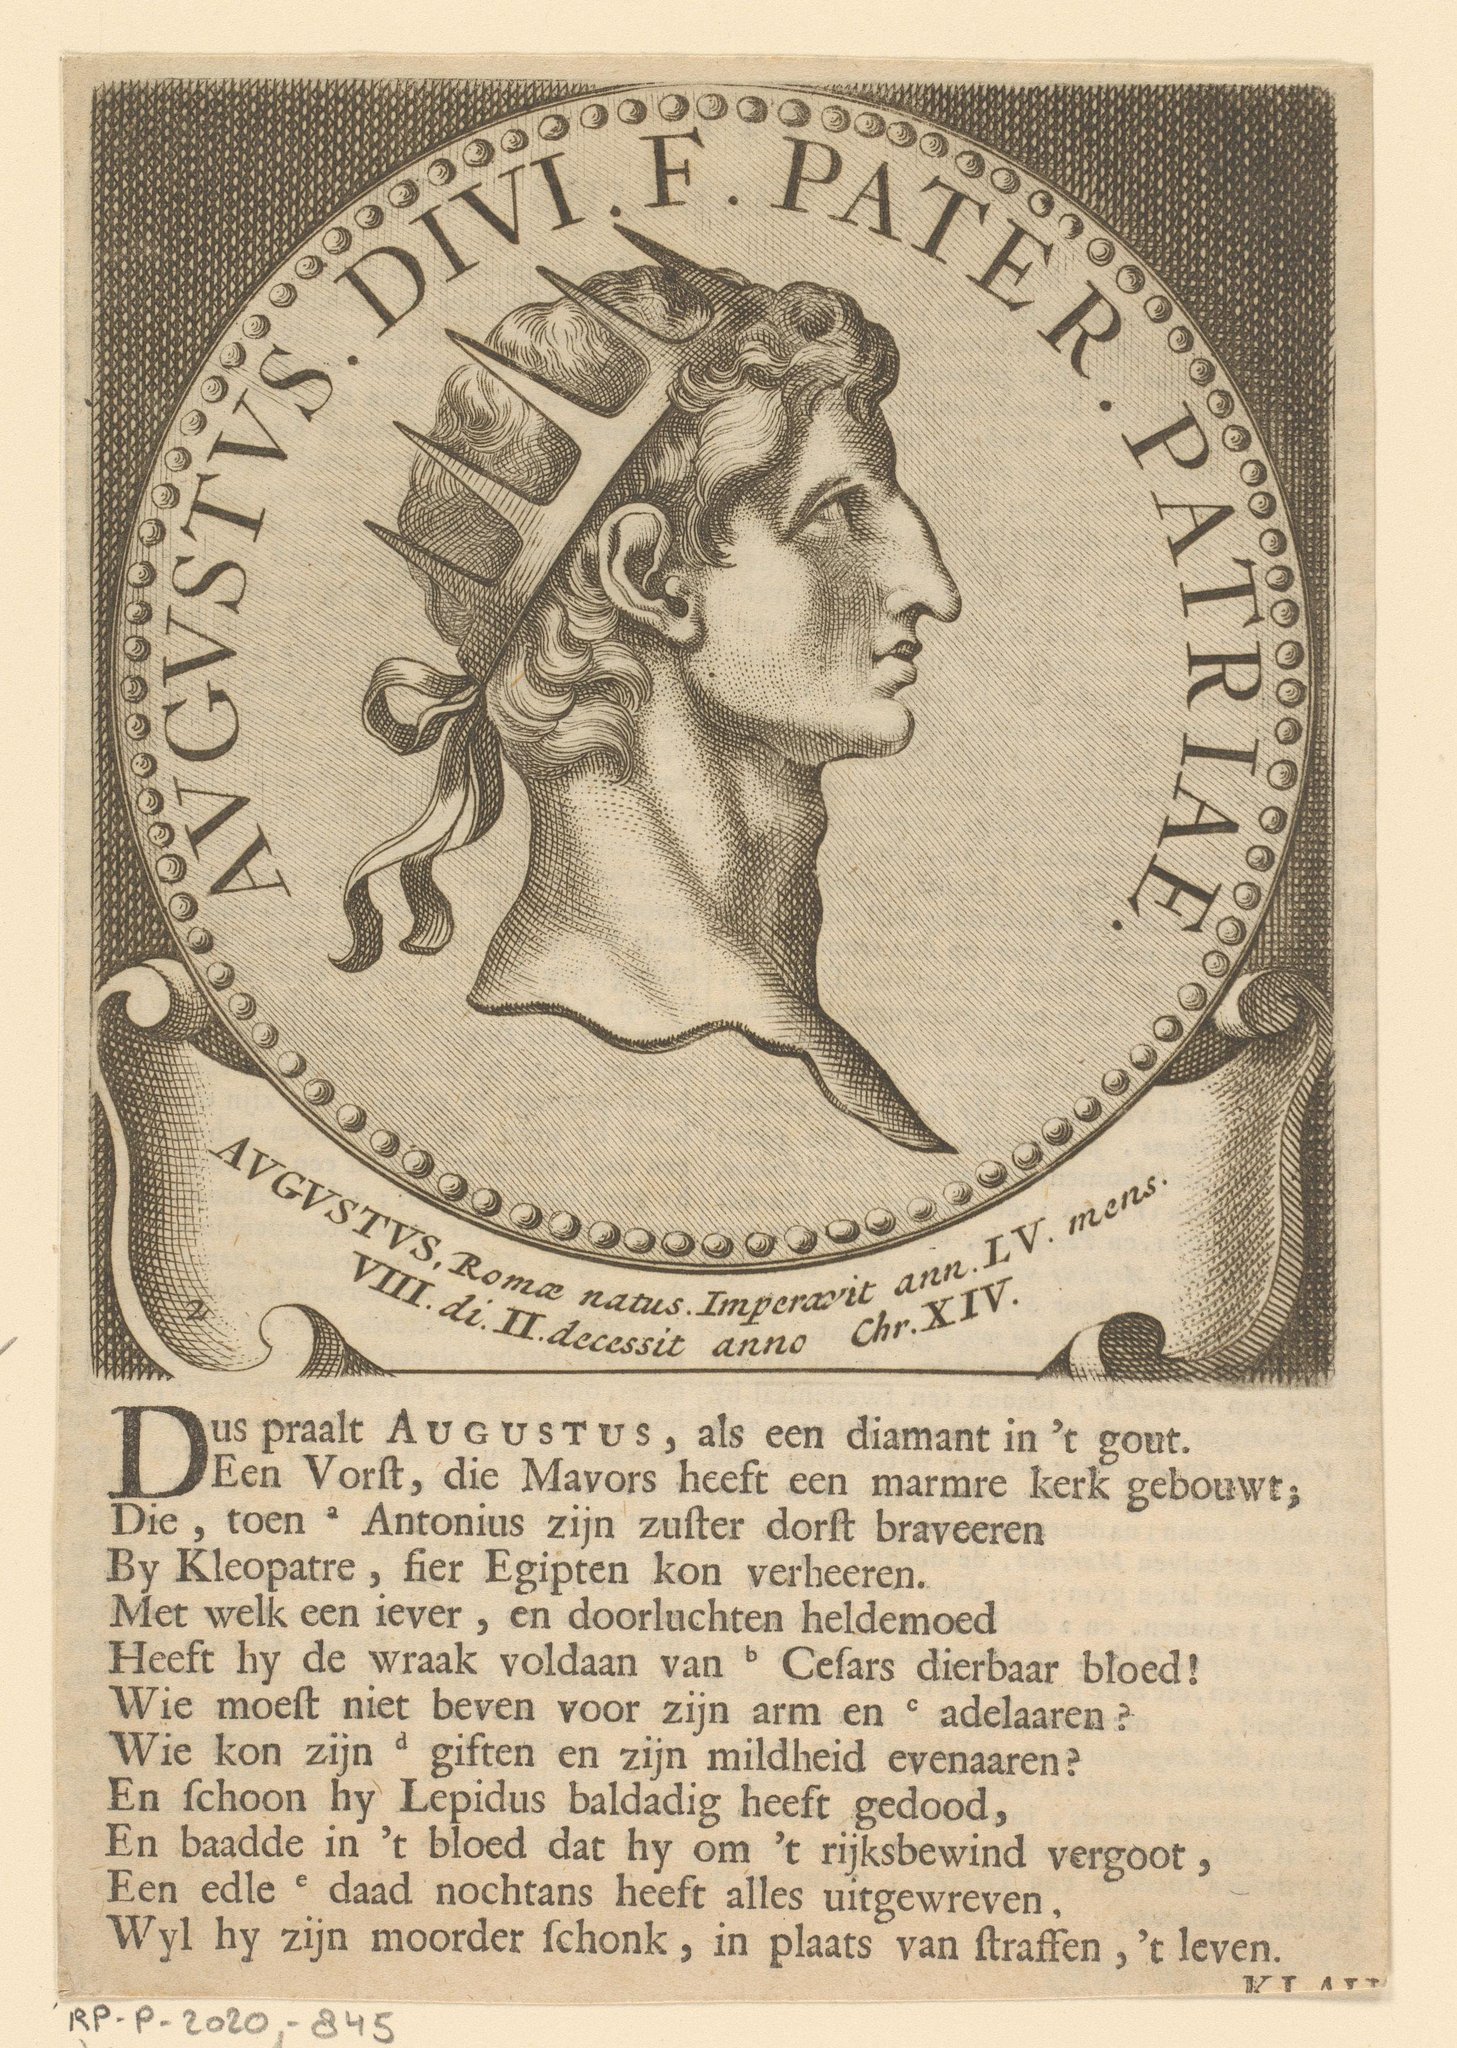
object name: book illustration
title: Augustus, Romae natus (...)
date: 1697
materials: paper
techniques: engraving, etching, letterpress printing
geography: utrecht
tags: portrait of augustus, historical persons, emperor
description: Prent uit: Bogaert, Abraham. De Roomsche monarchy, vertoont in de muntbeelden der westersche en oostersche keizeren (...). Utrecht: François Halma en Willem van de Water, 1697, p. 111. Eerste staat verschenen in een grotere prent met twaalf portretten, gedateerd 1695.